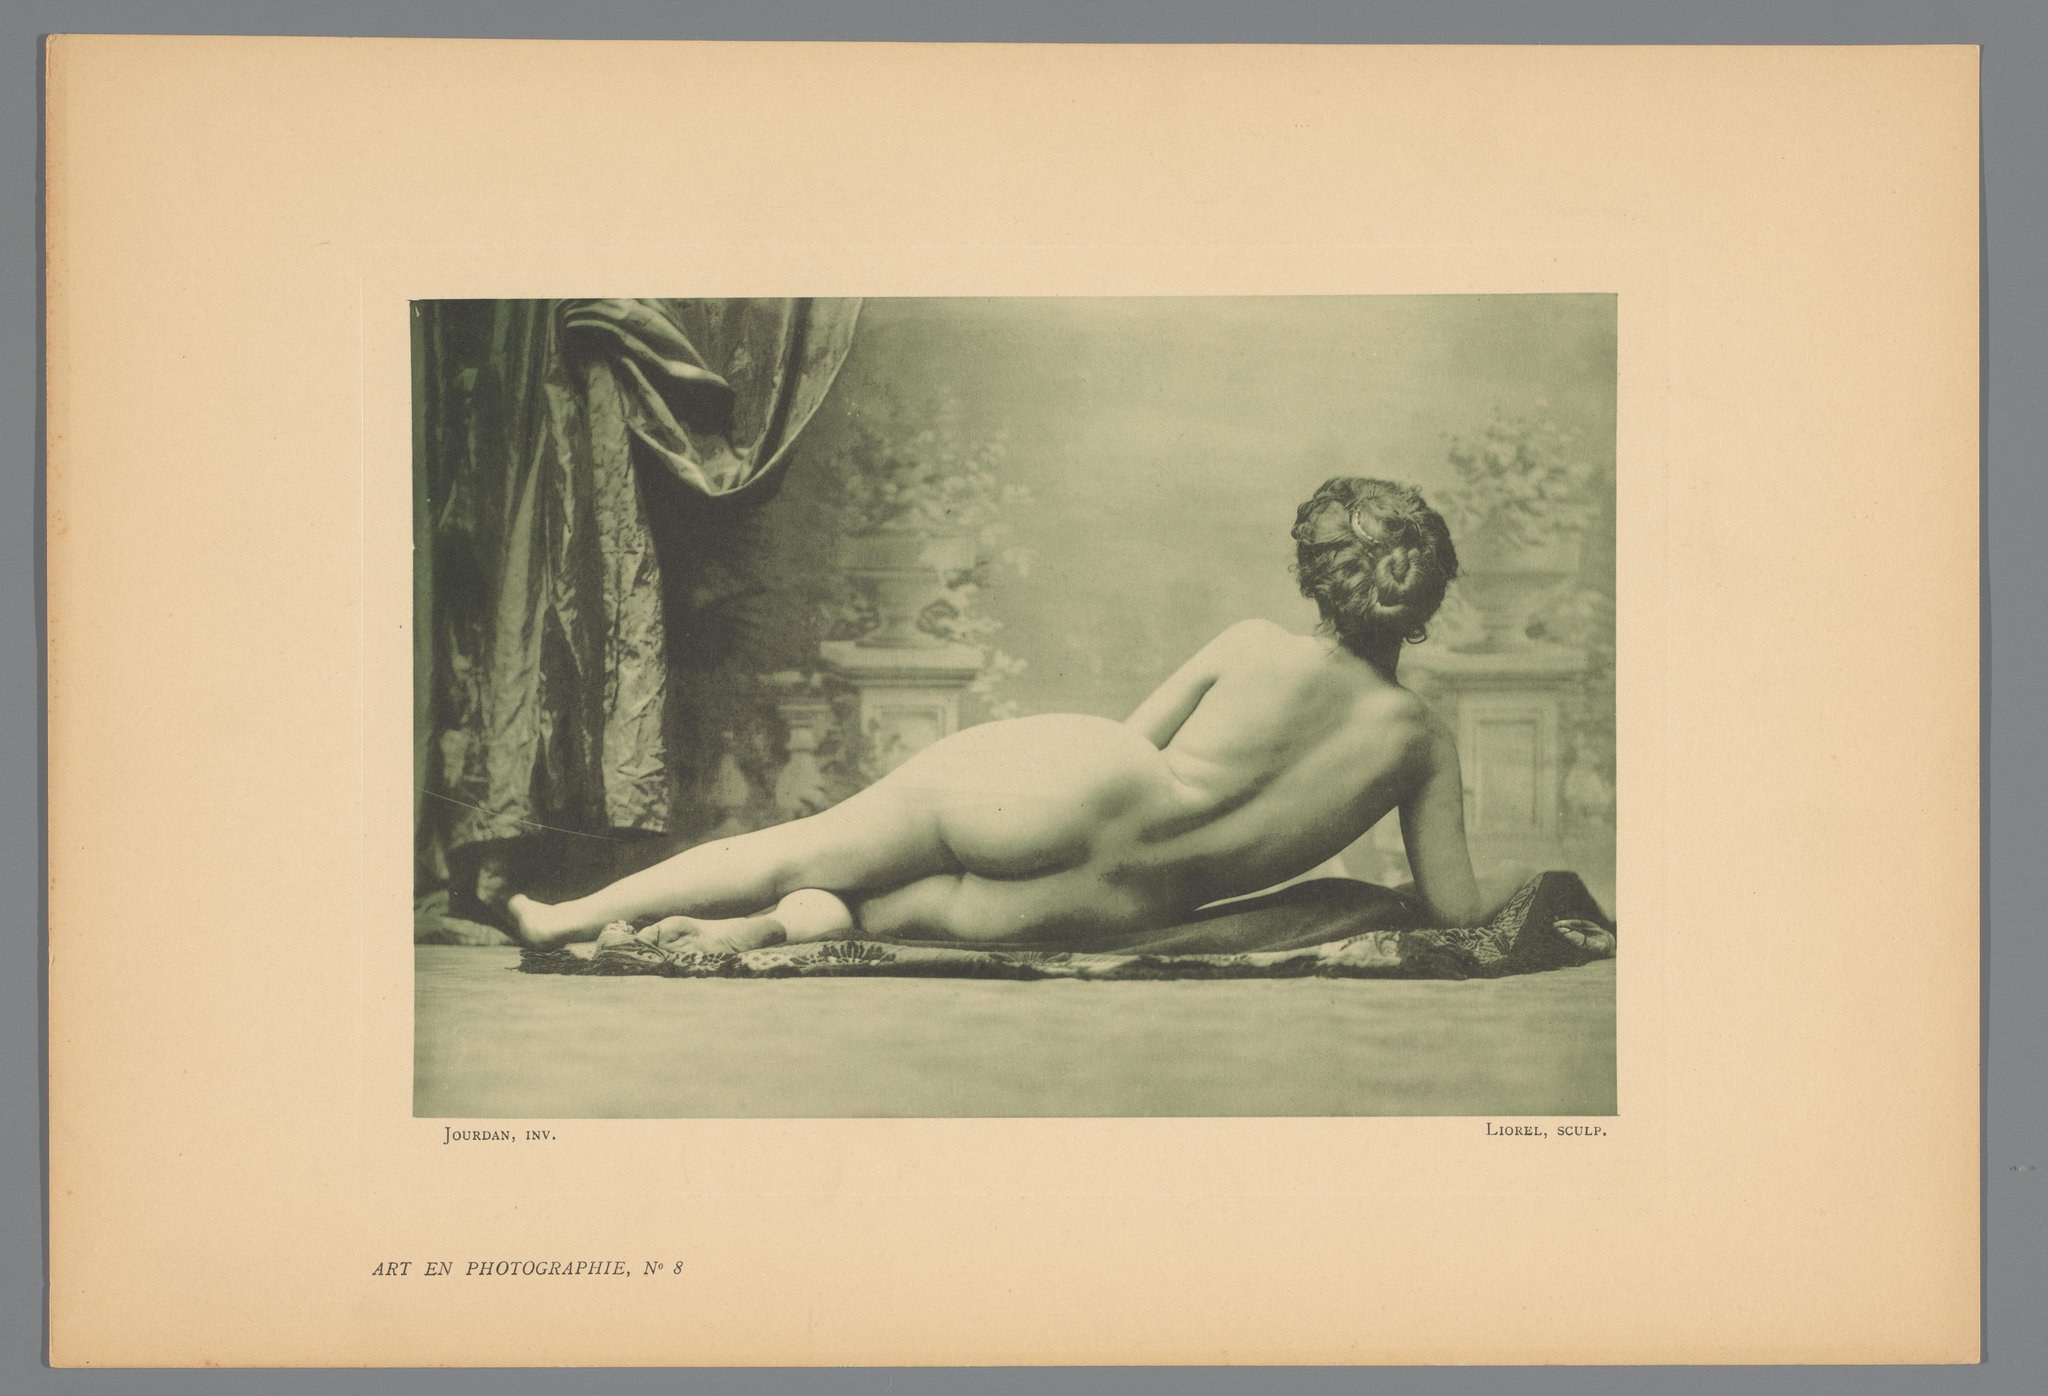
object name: photomechanical print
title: Liggende naakte vrouw, op de rug gezien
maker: jourdan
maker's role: fotograaf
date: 1896-1901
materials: paper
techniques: photograph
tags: lying on one side, with uplifted upper part of the body and leaning on the arm - aa - female human figure, woman (showing herself) undressed, quasi-nude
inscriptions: number: ‘NB 186’, inscription: ‘ART EN PHOTOGRAPHIE, No 8’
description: Deze prent maakt deel uit van een omslag met 54 prenten op 52 bladen.